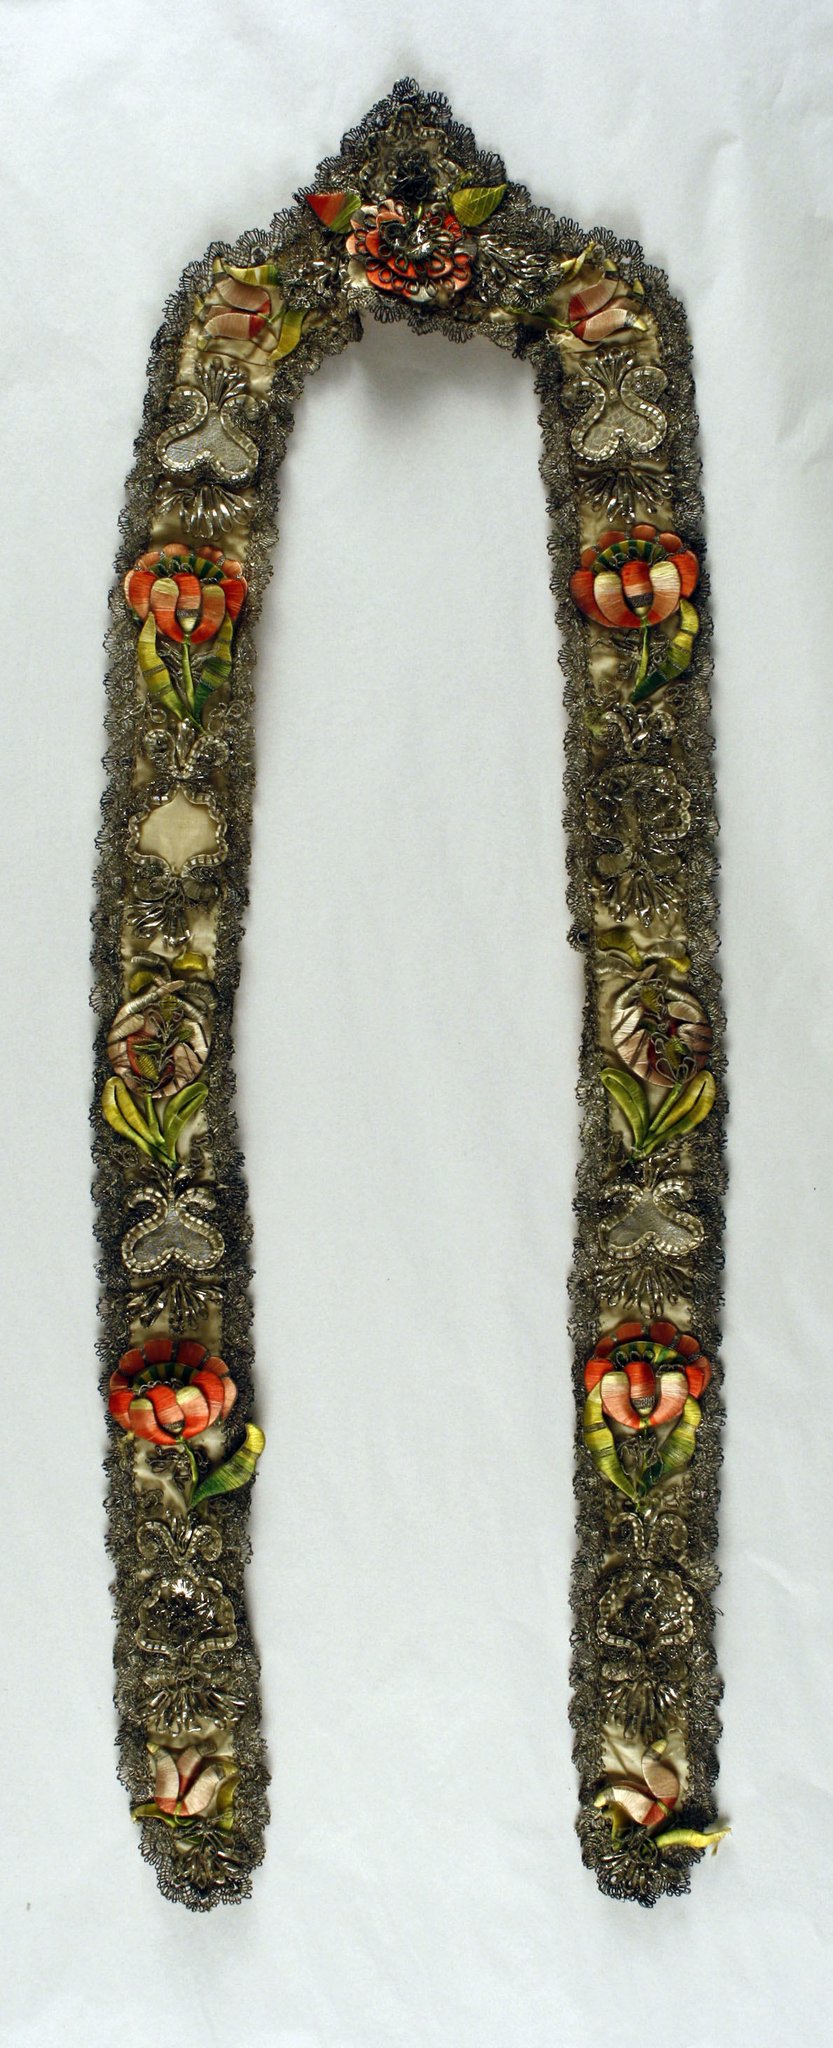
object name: trimming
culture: french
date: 1750-1775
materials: metal, silk